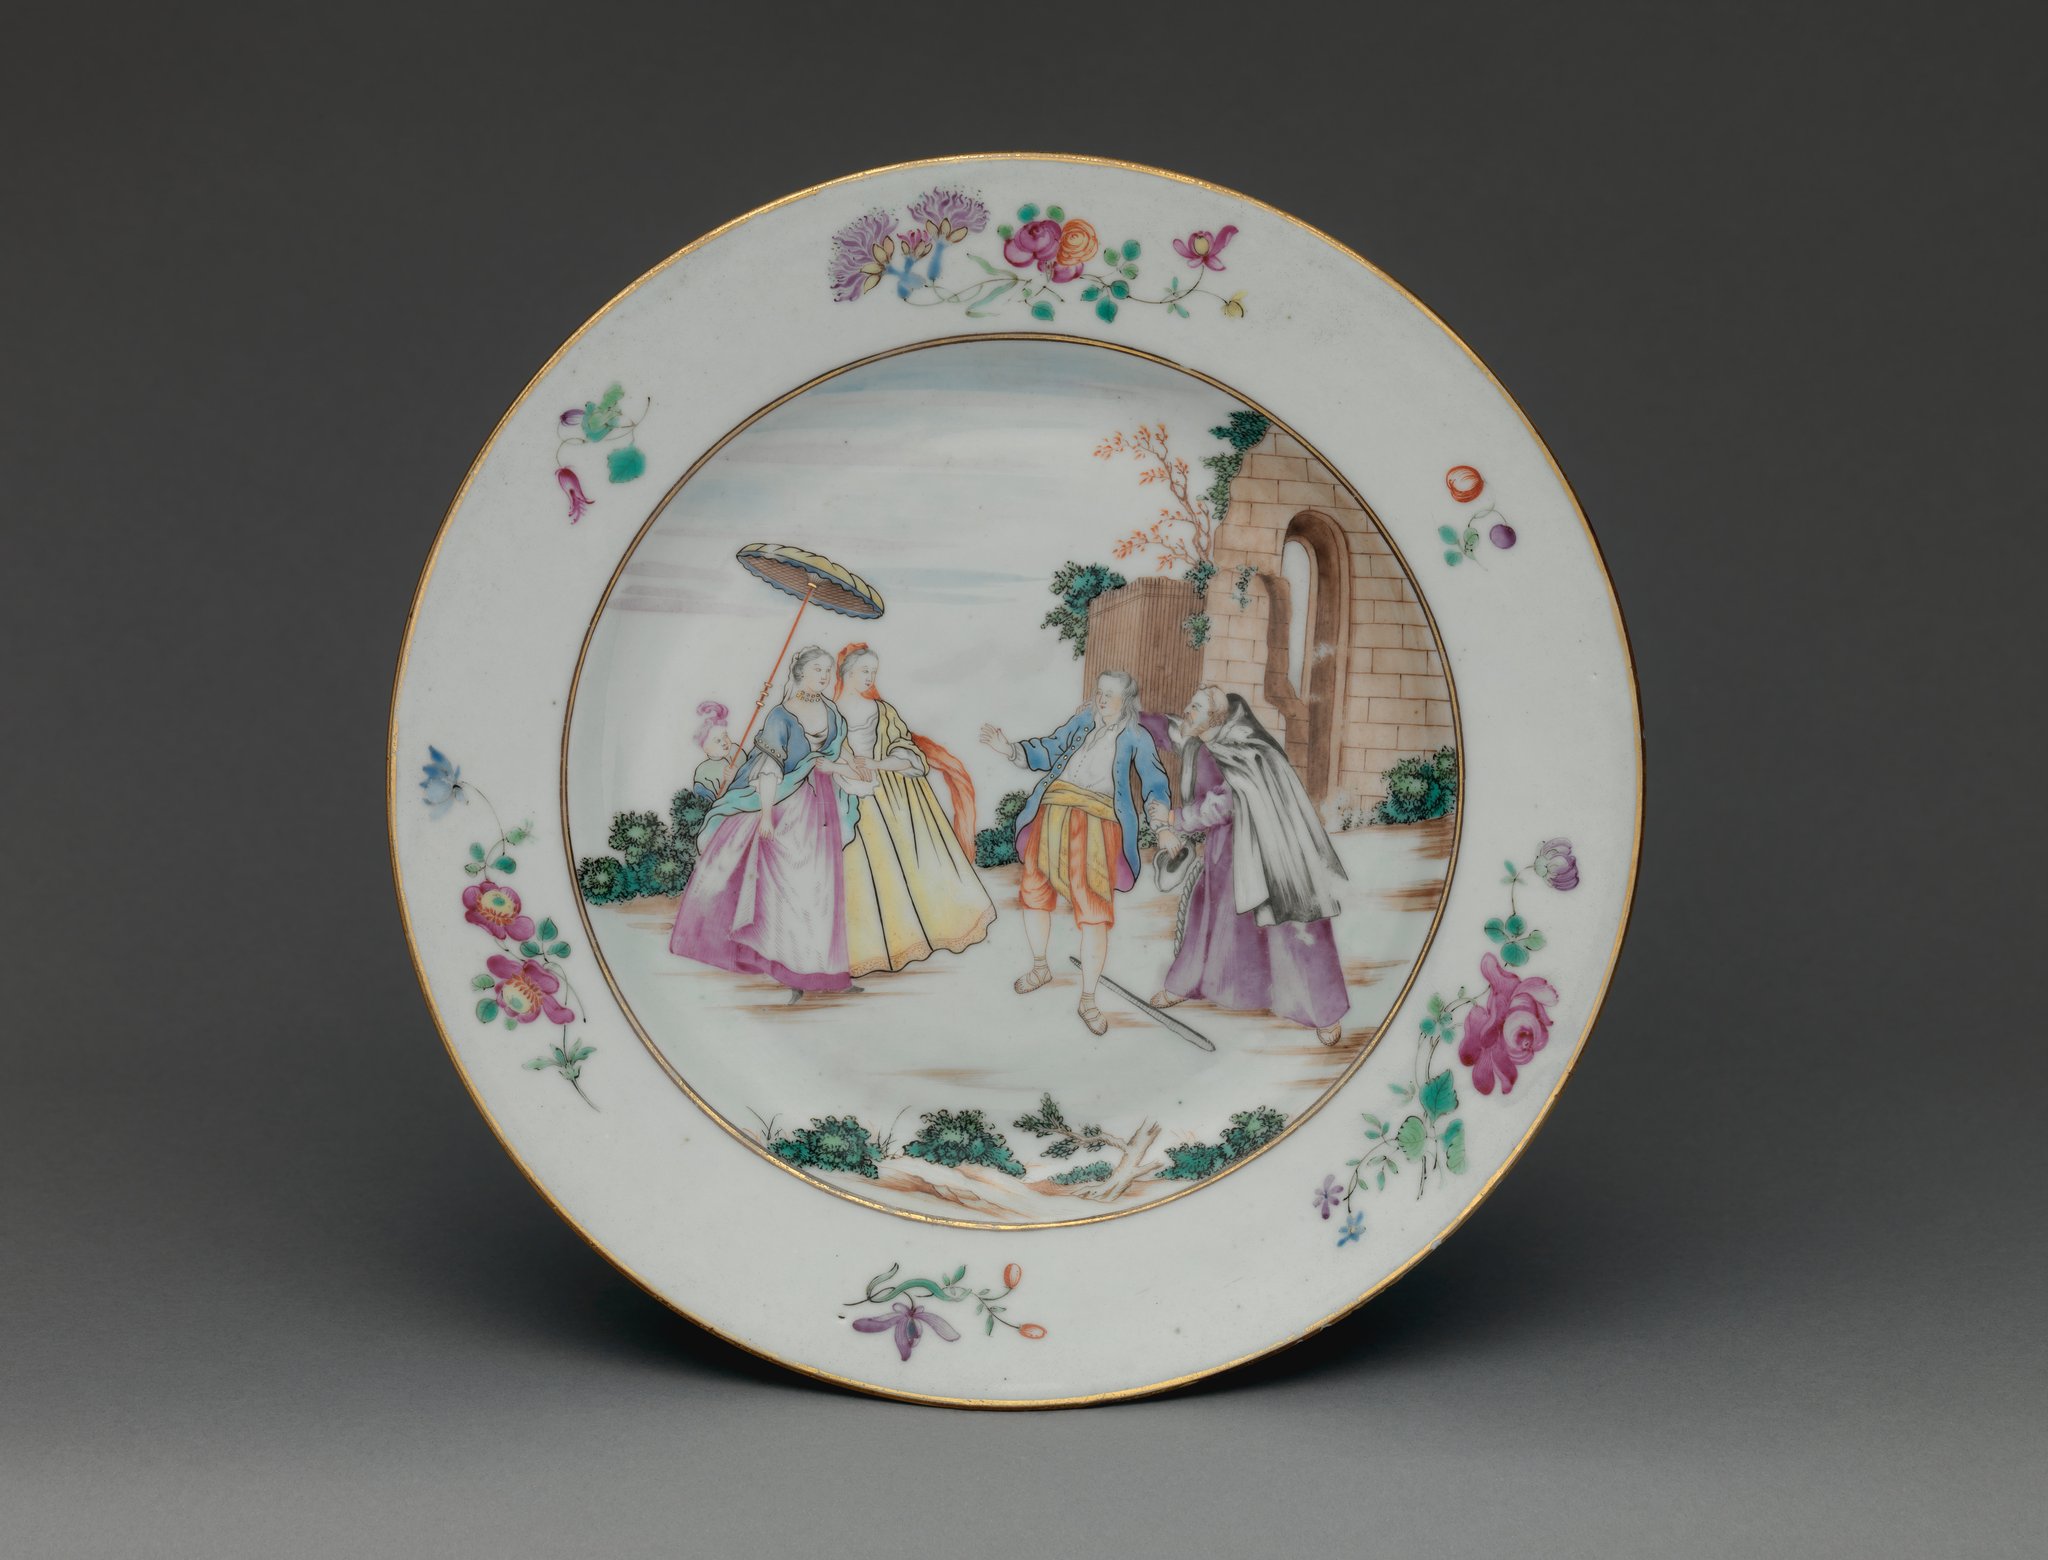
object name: plate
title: Plate with scene from "Les Oies de Frère Philippe"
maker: nicolas lancret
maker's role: artist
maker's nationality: french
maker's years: 1690-1743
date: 1745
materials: porcelain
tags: men,women